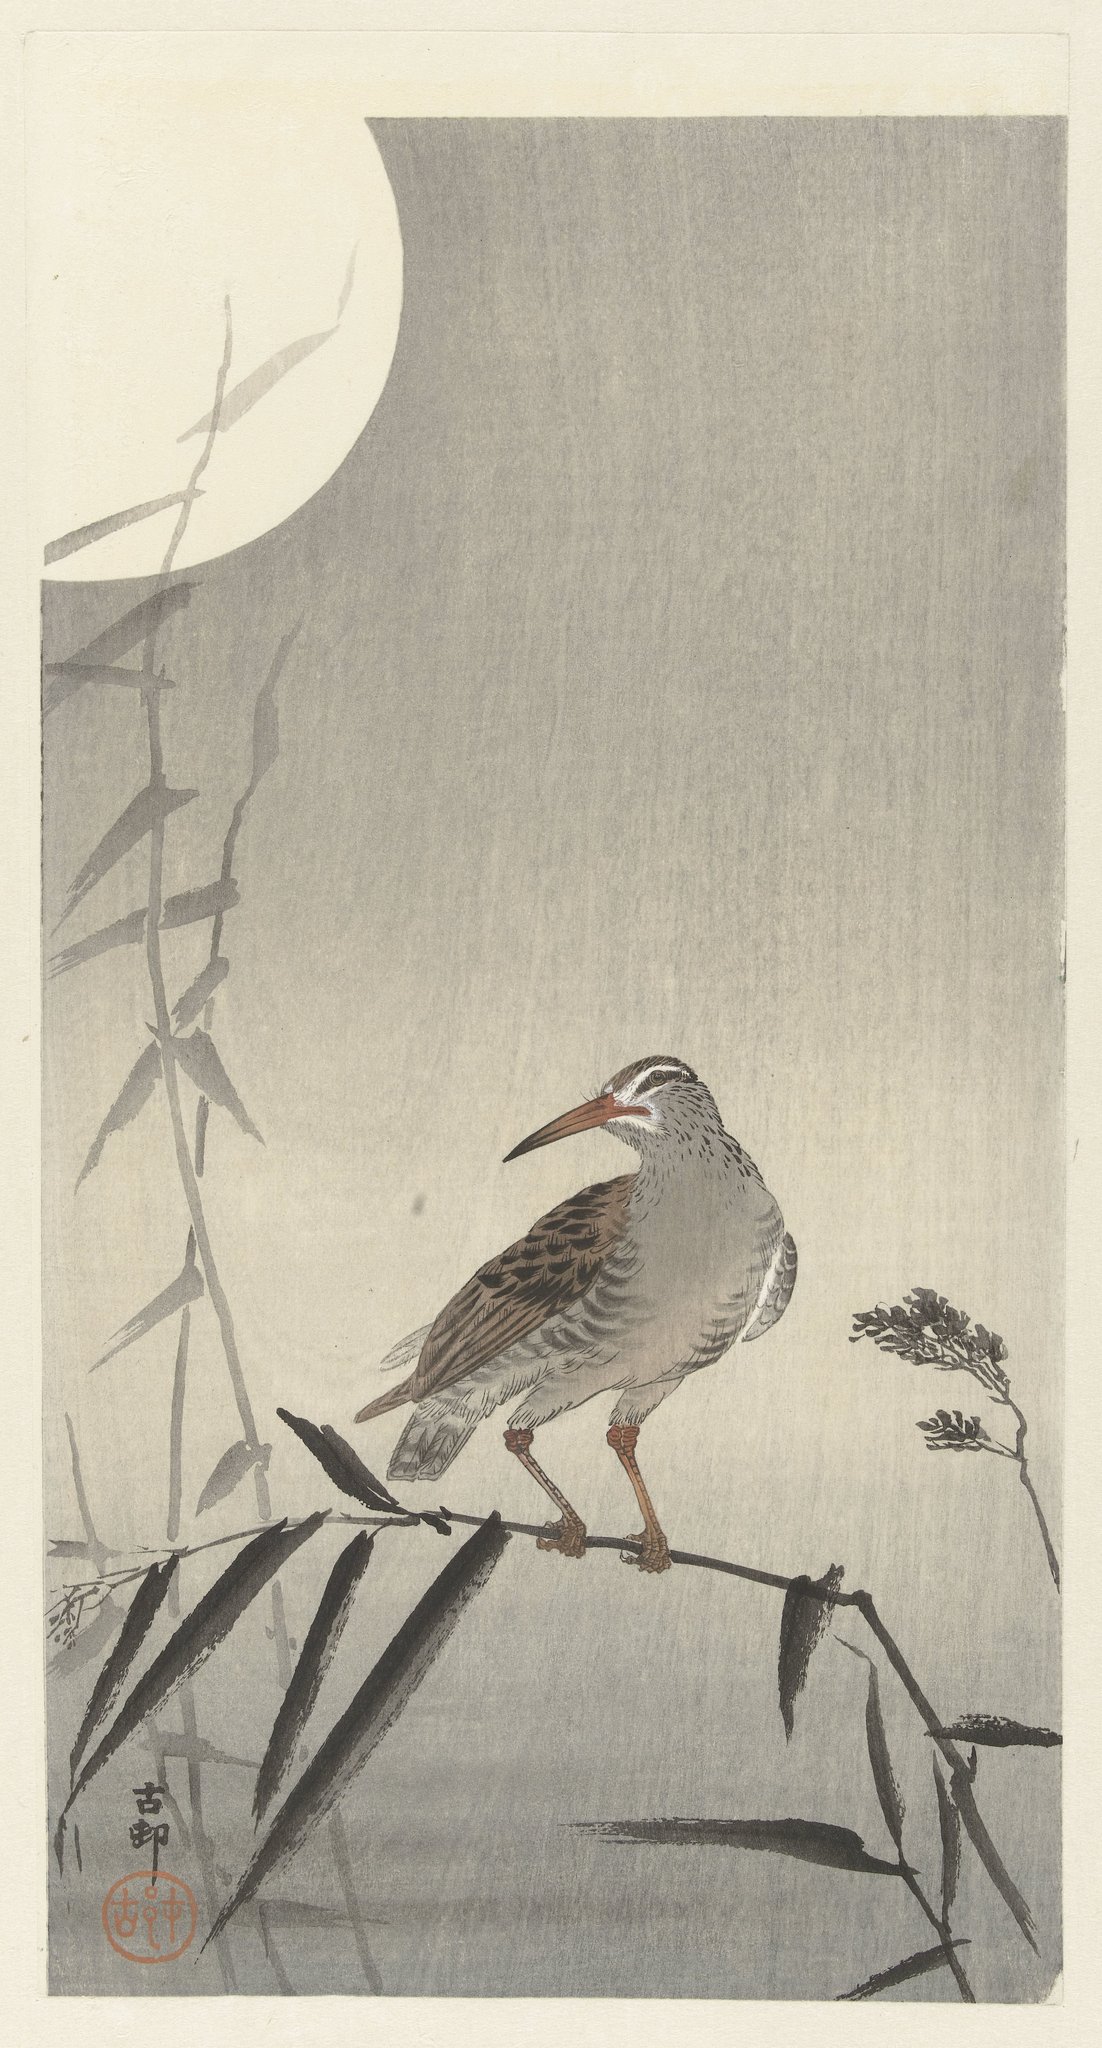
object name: print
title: Vogel op rietstengel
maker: ohara koson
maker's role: print maker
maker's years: 1877-1945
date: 1900-1936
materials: paper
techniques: woodcut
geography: japan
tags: full moon, plants and herbs: bamboo, birds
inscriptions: collector's mark: Lugt 2228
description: Vogel op rietstengel, naar links kijkend, bij volle maan; tegen grijze achtergrond.